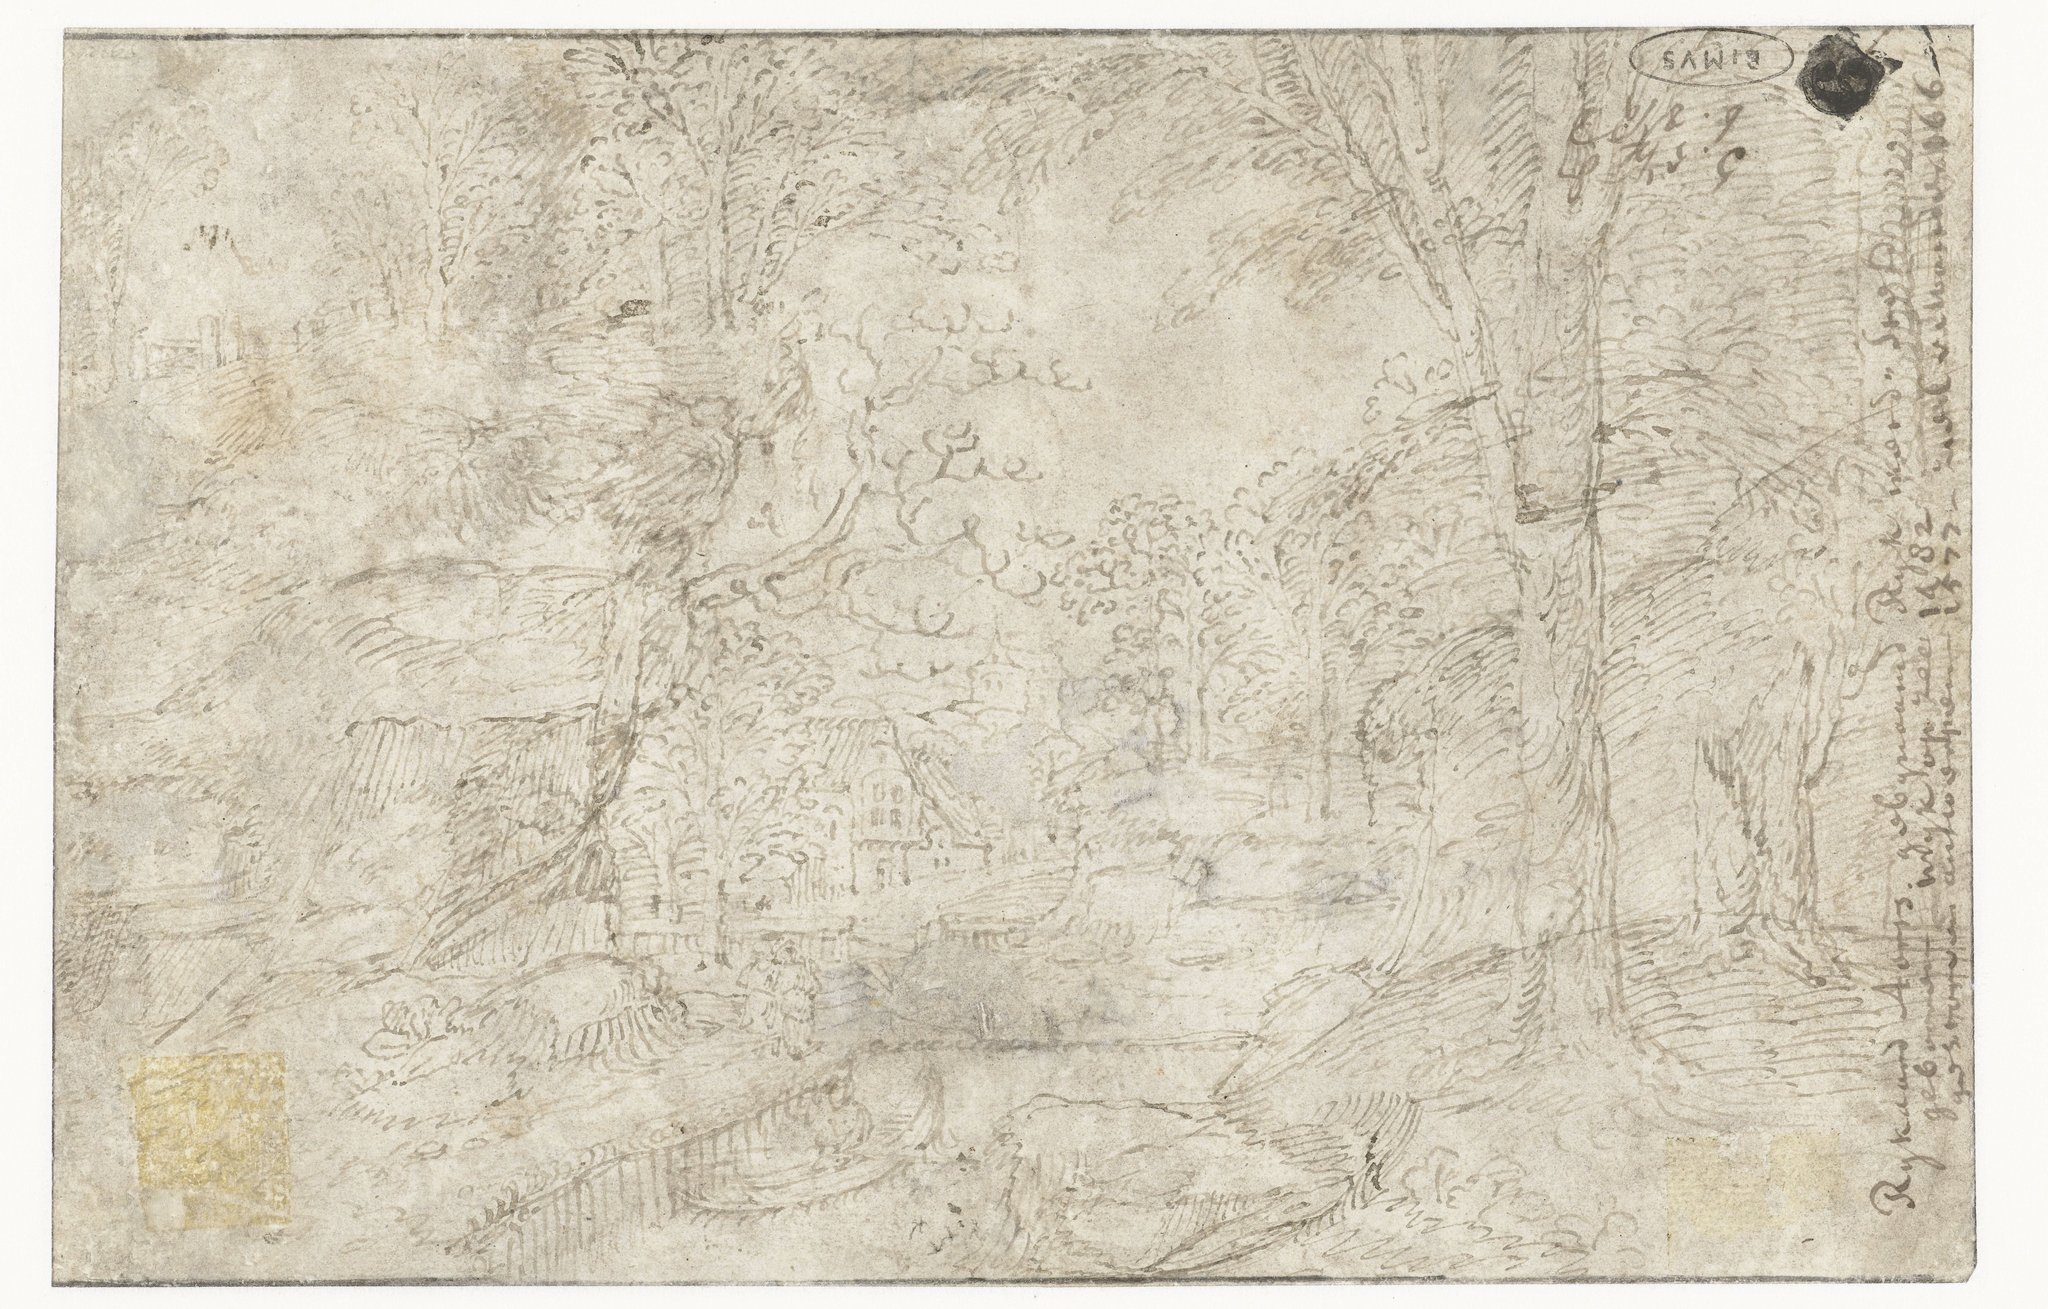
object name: drawing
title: Heuvelachtig landschap met boerderij en rivier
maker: Anonymous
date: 1540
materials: ink, paper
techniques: pen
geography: southern netherlands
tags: farm or solitary house in landscape